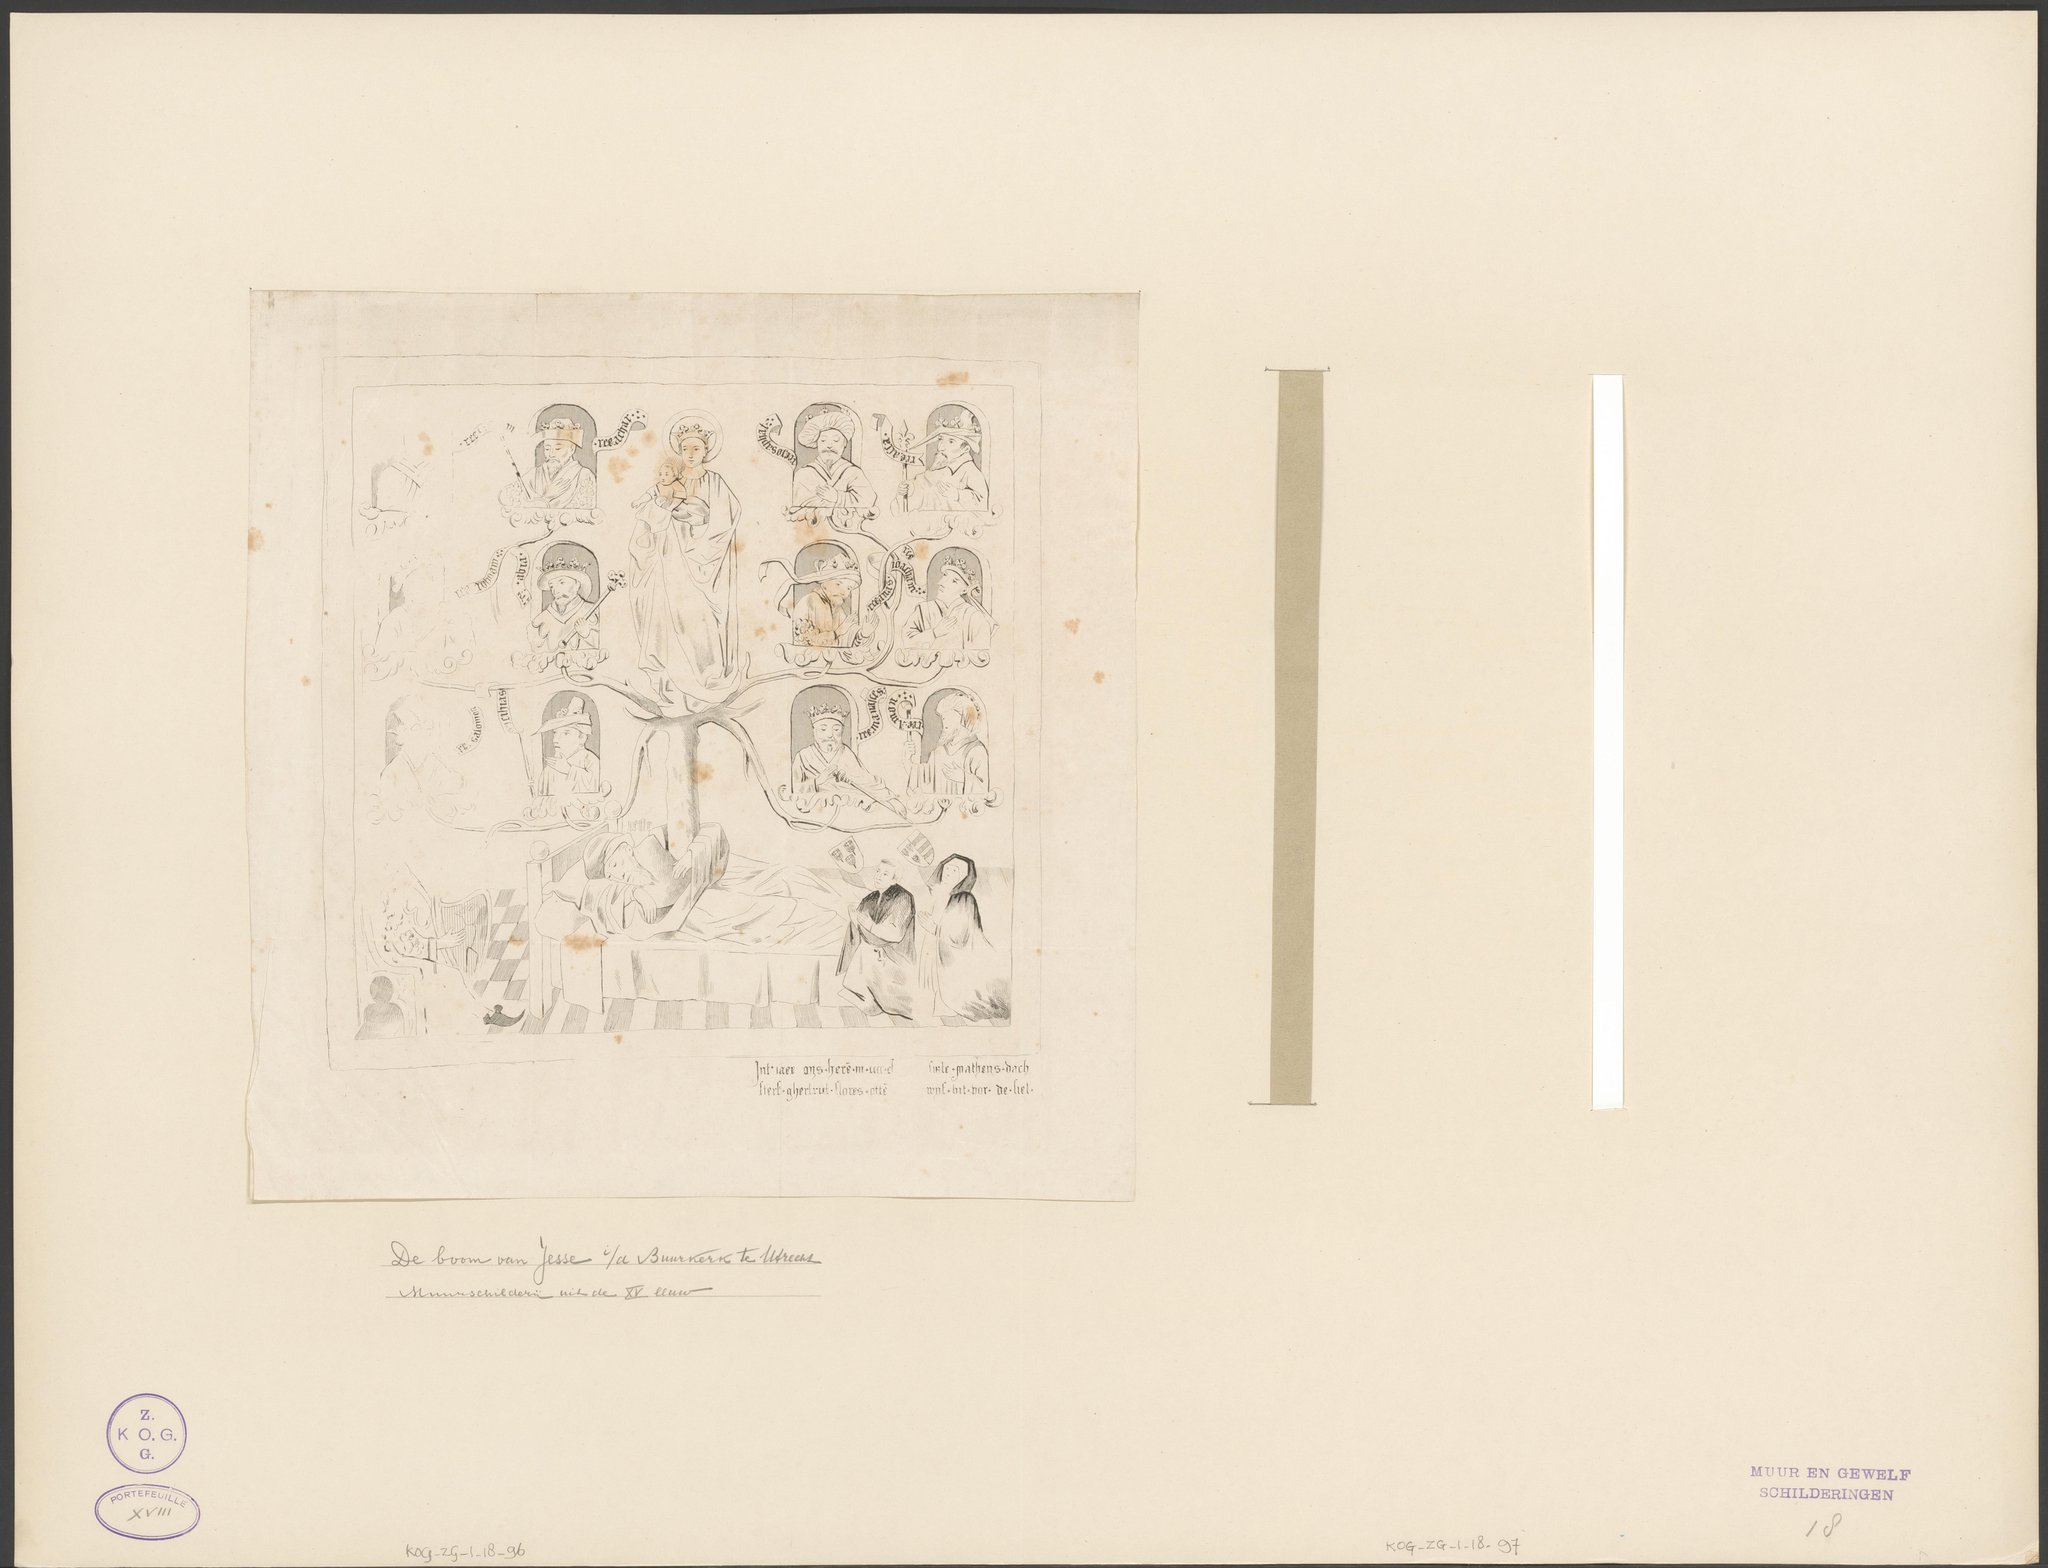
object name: print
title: Muurschildering van de boom van Jesse uit de Buurkerk te Utrecht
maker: Anonymous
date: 1800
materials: paper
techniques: lithograph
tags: tree of jesse: genealogical tree showing christ's ancestors, sprouting from jesse's loins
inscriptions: collector's mark: Lugt 1641, stamp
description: Onderwerpsrubrieken binnen de Atlas Zeden en Gewoonten: Schoone kunsten, Muur- en gewelfschilderingen.